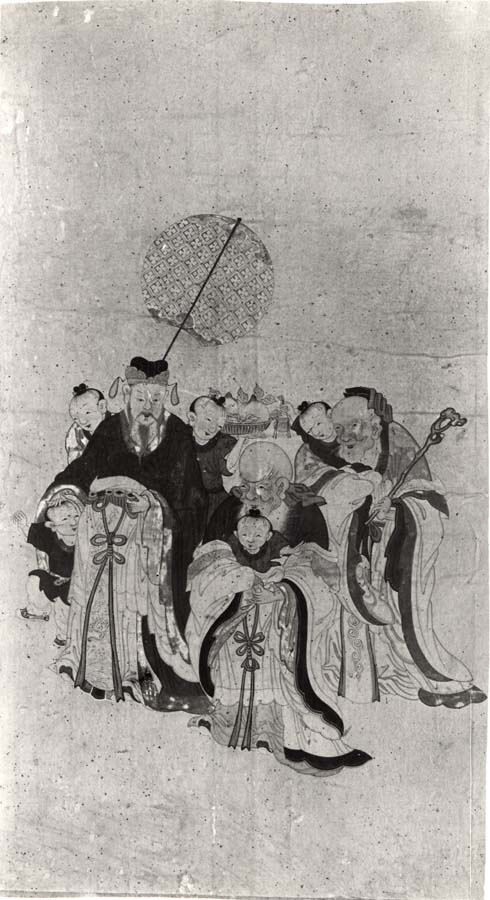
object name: album leaf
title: Wise Men and Children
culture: korean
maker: unidentified artist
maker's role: artist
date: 1801-1900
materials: ink, paper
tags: children,men